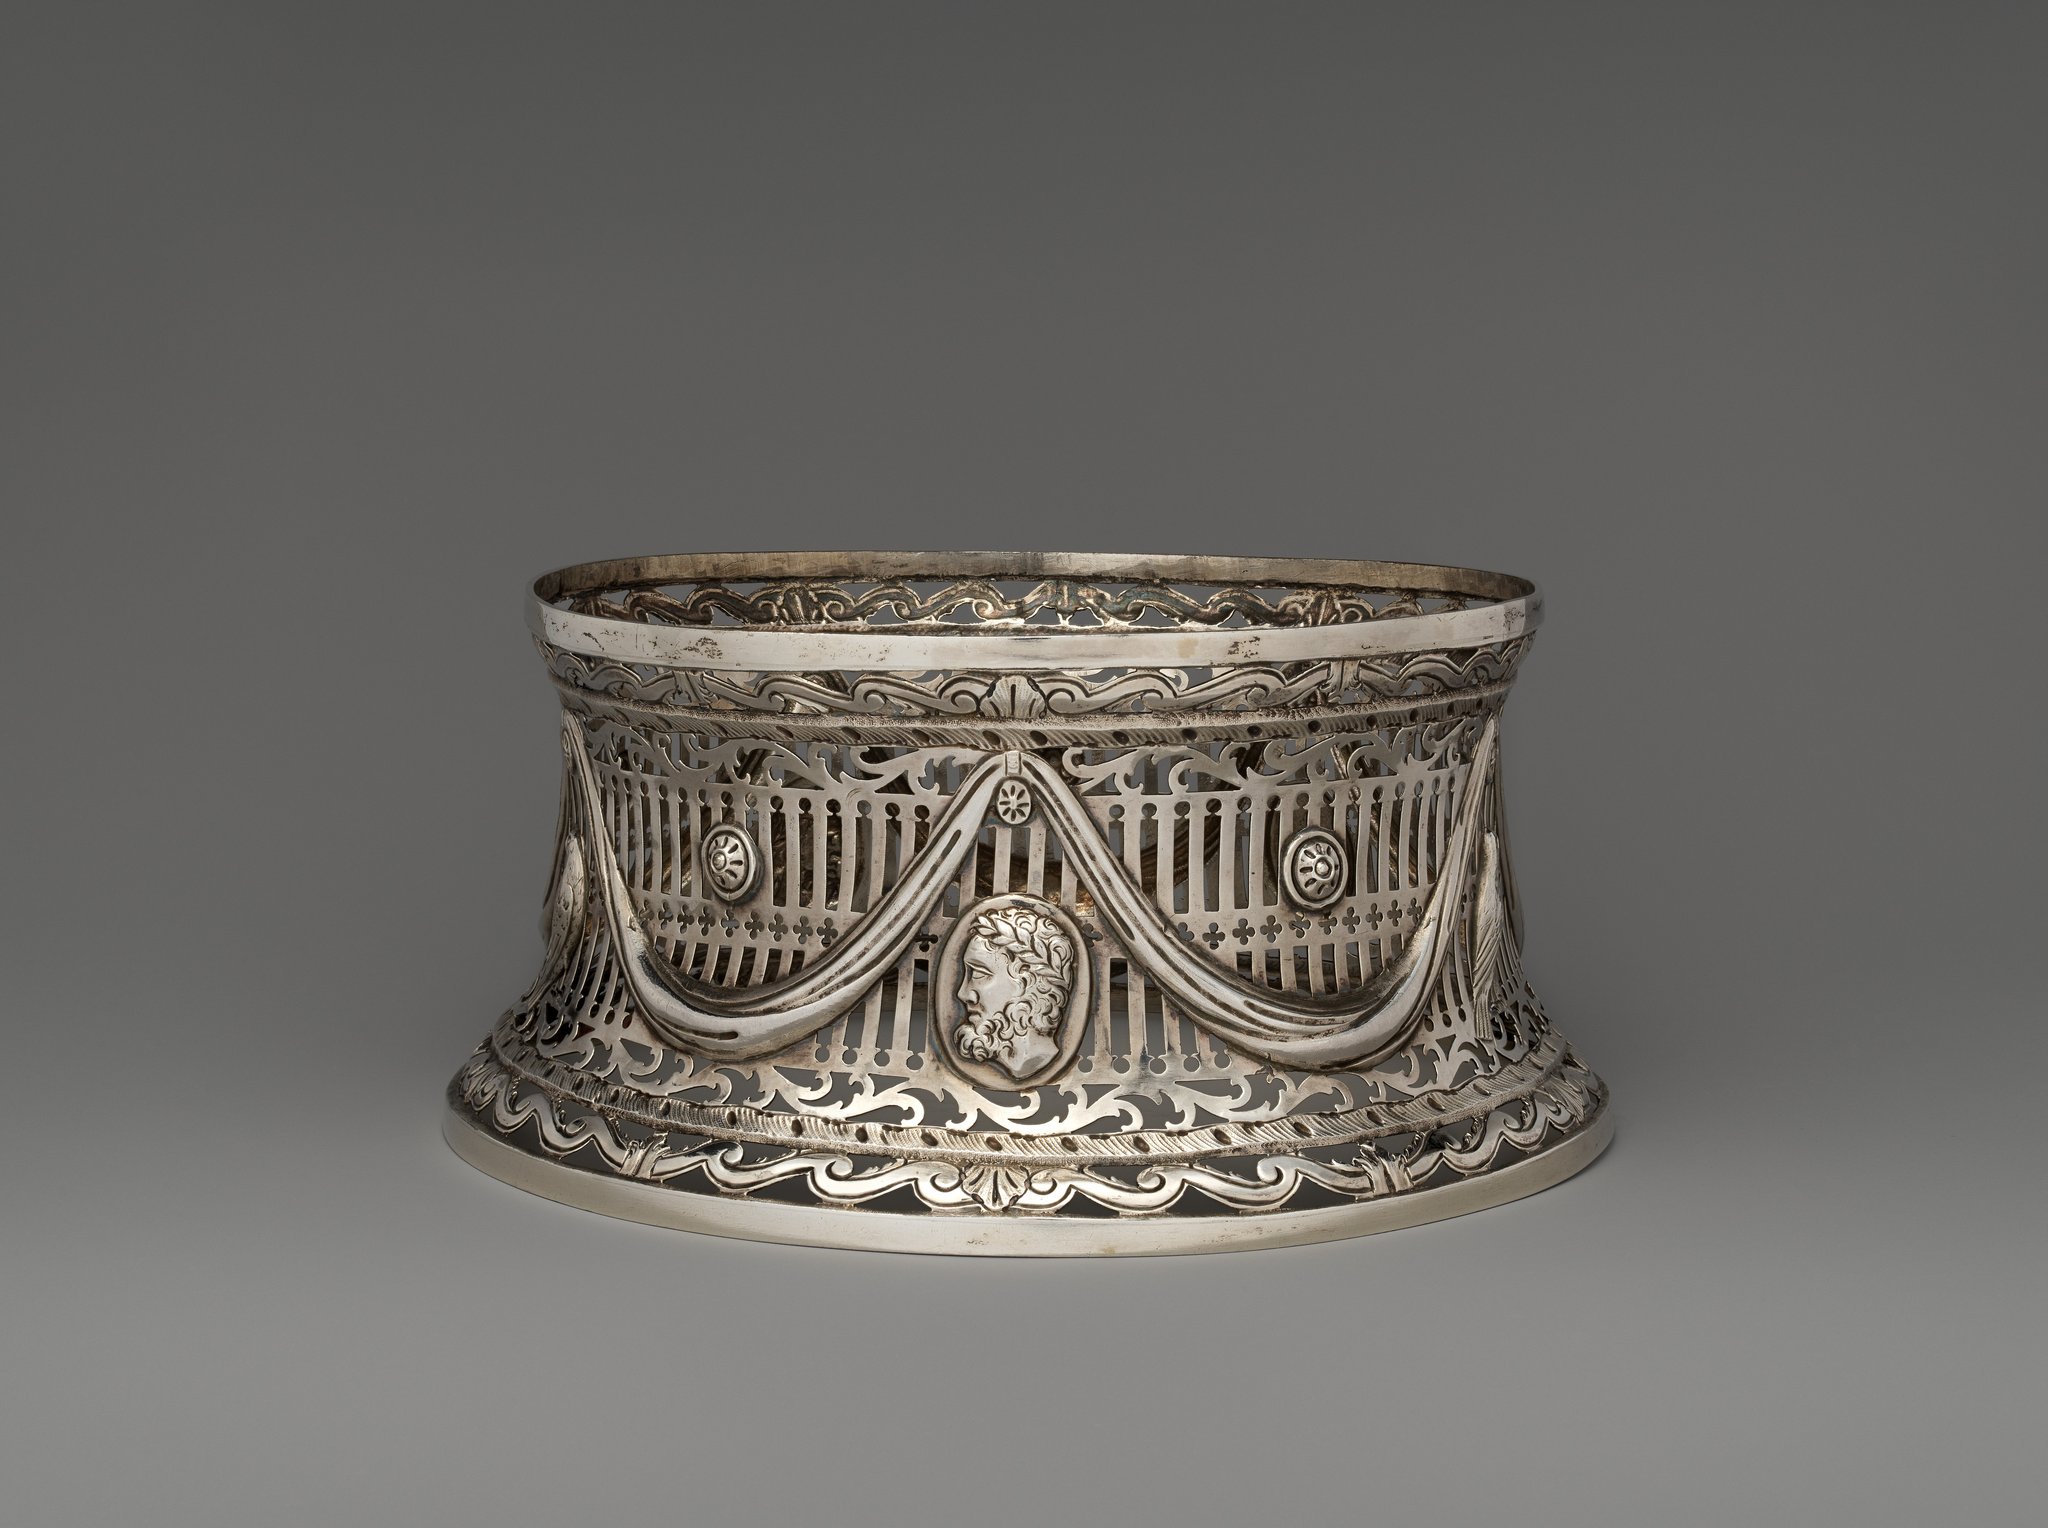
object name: dish ring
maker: w. h.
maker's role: maker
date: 1777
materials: silver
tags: birds,men,profiles